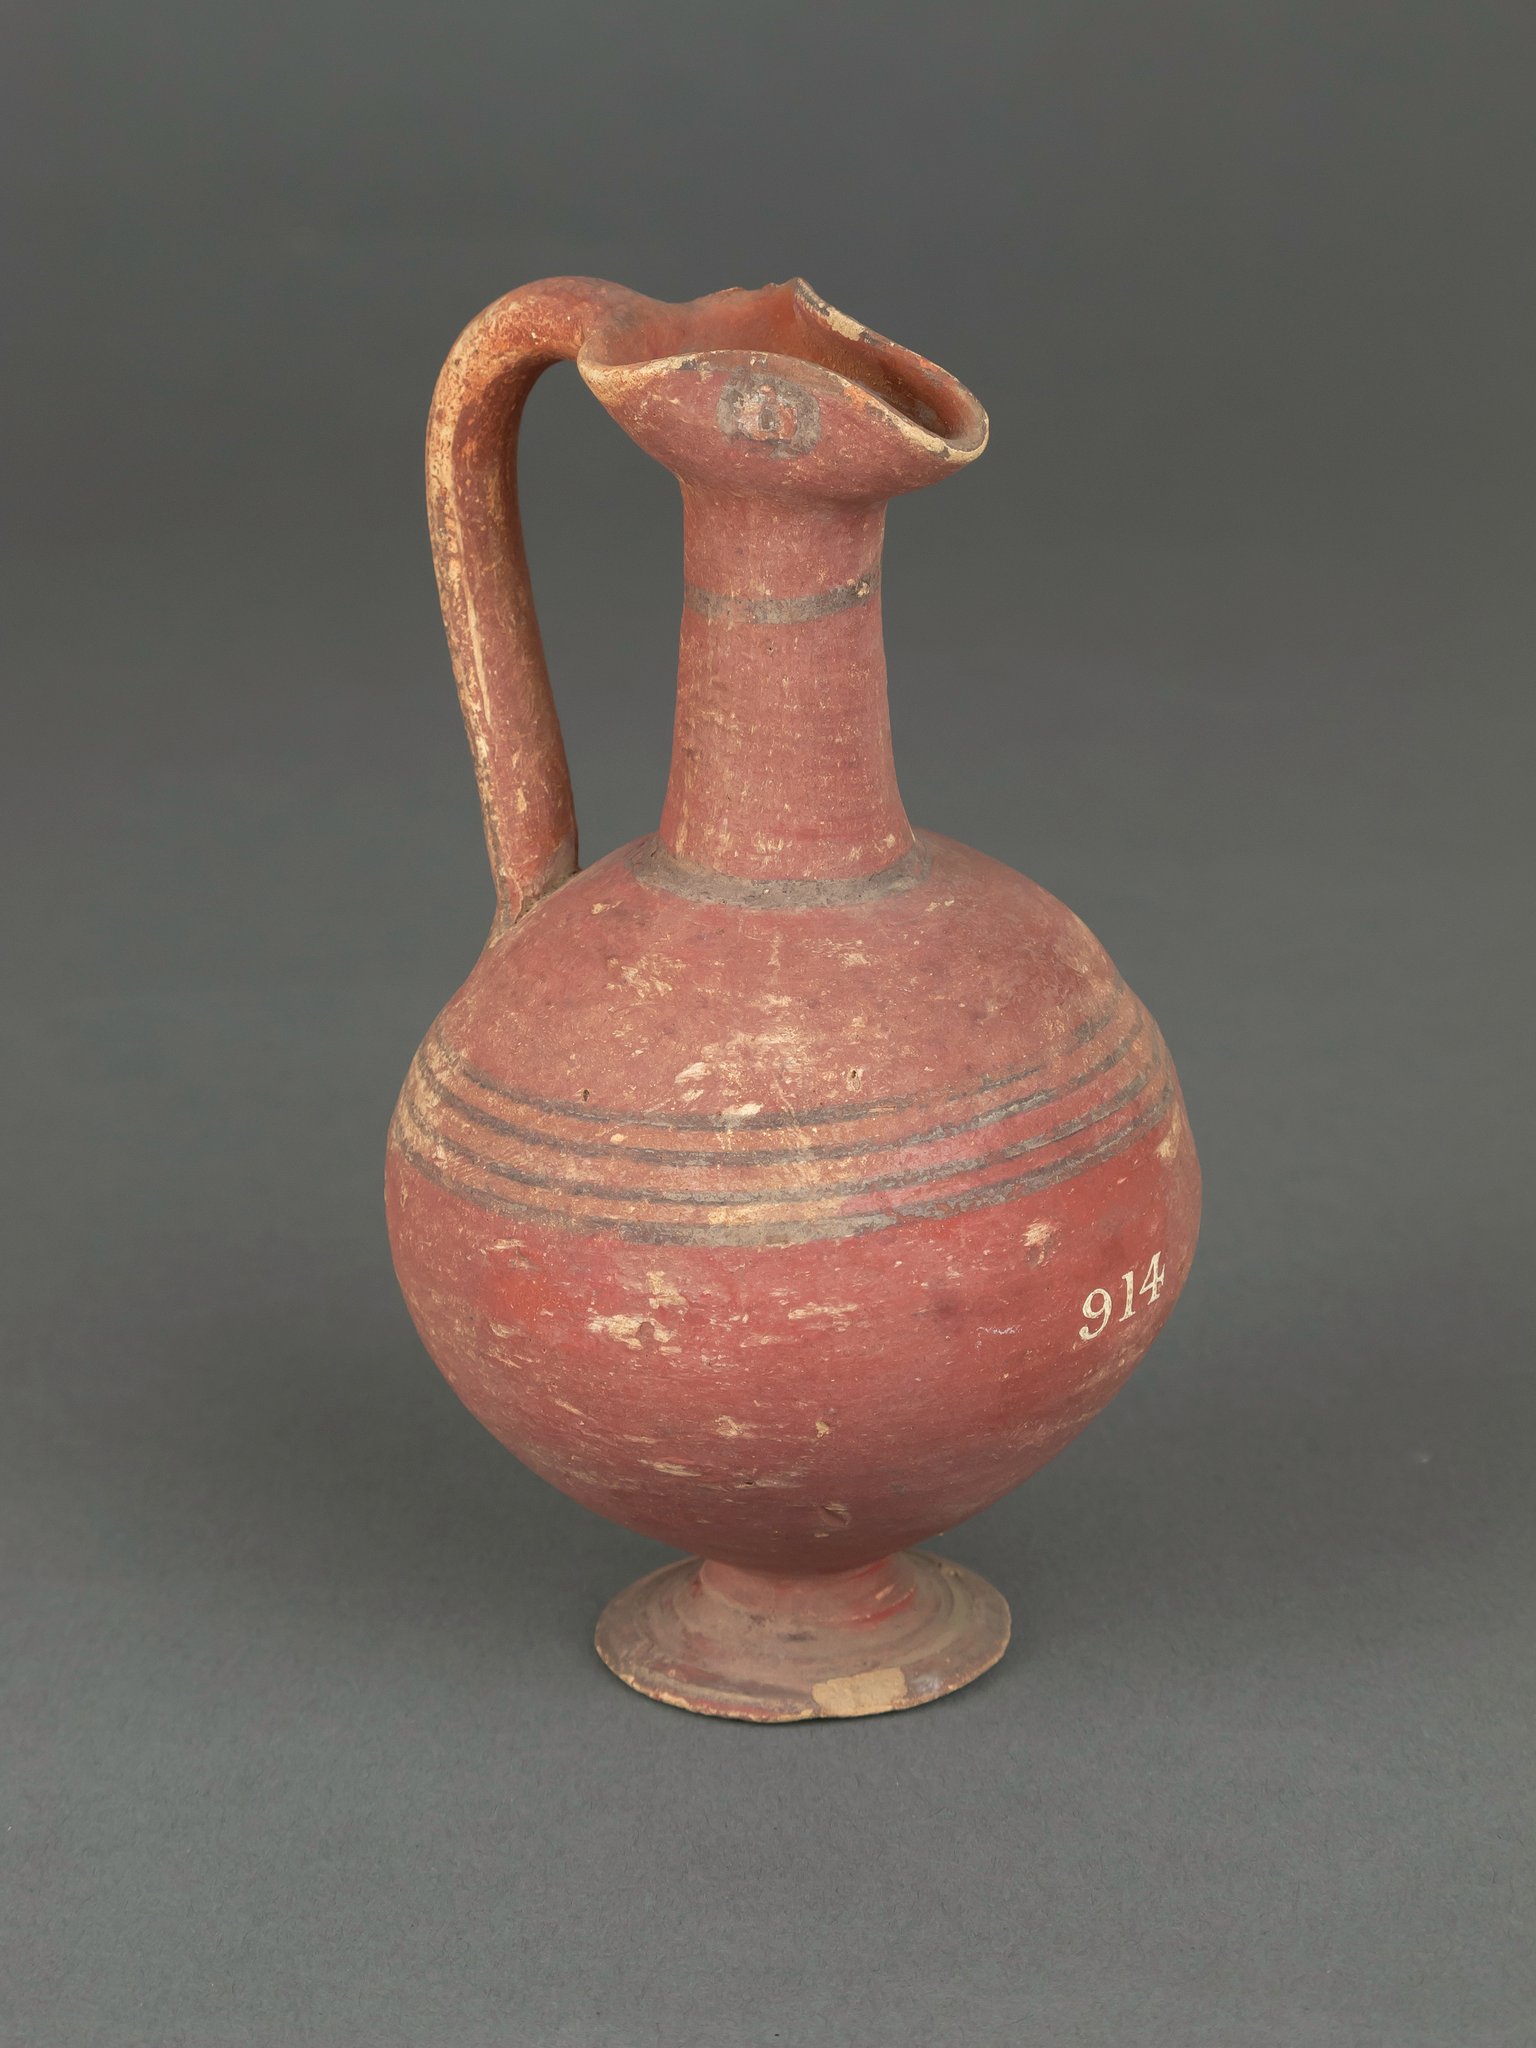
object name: jug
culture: cypriot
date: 750-600 BCE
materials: terracotta